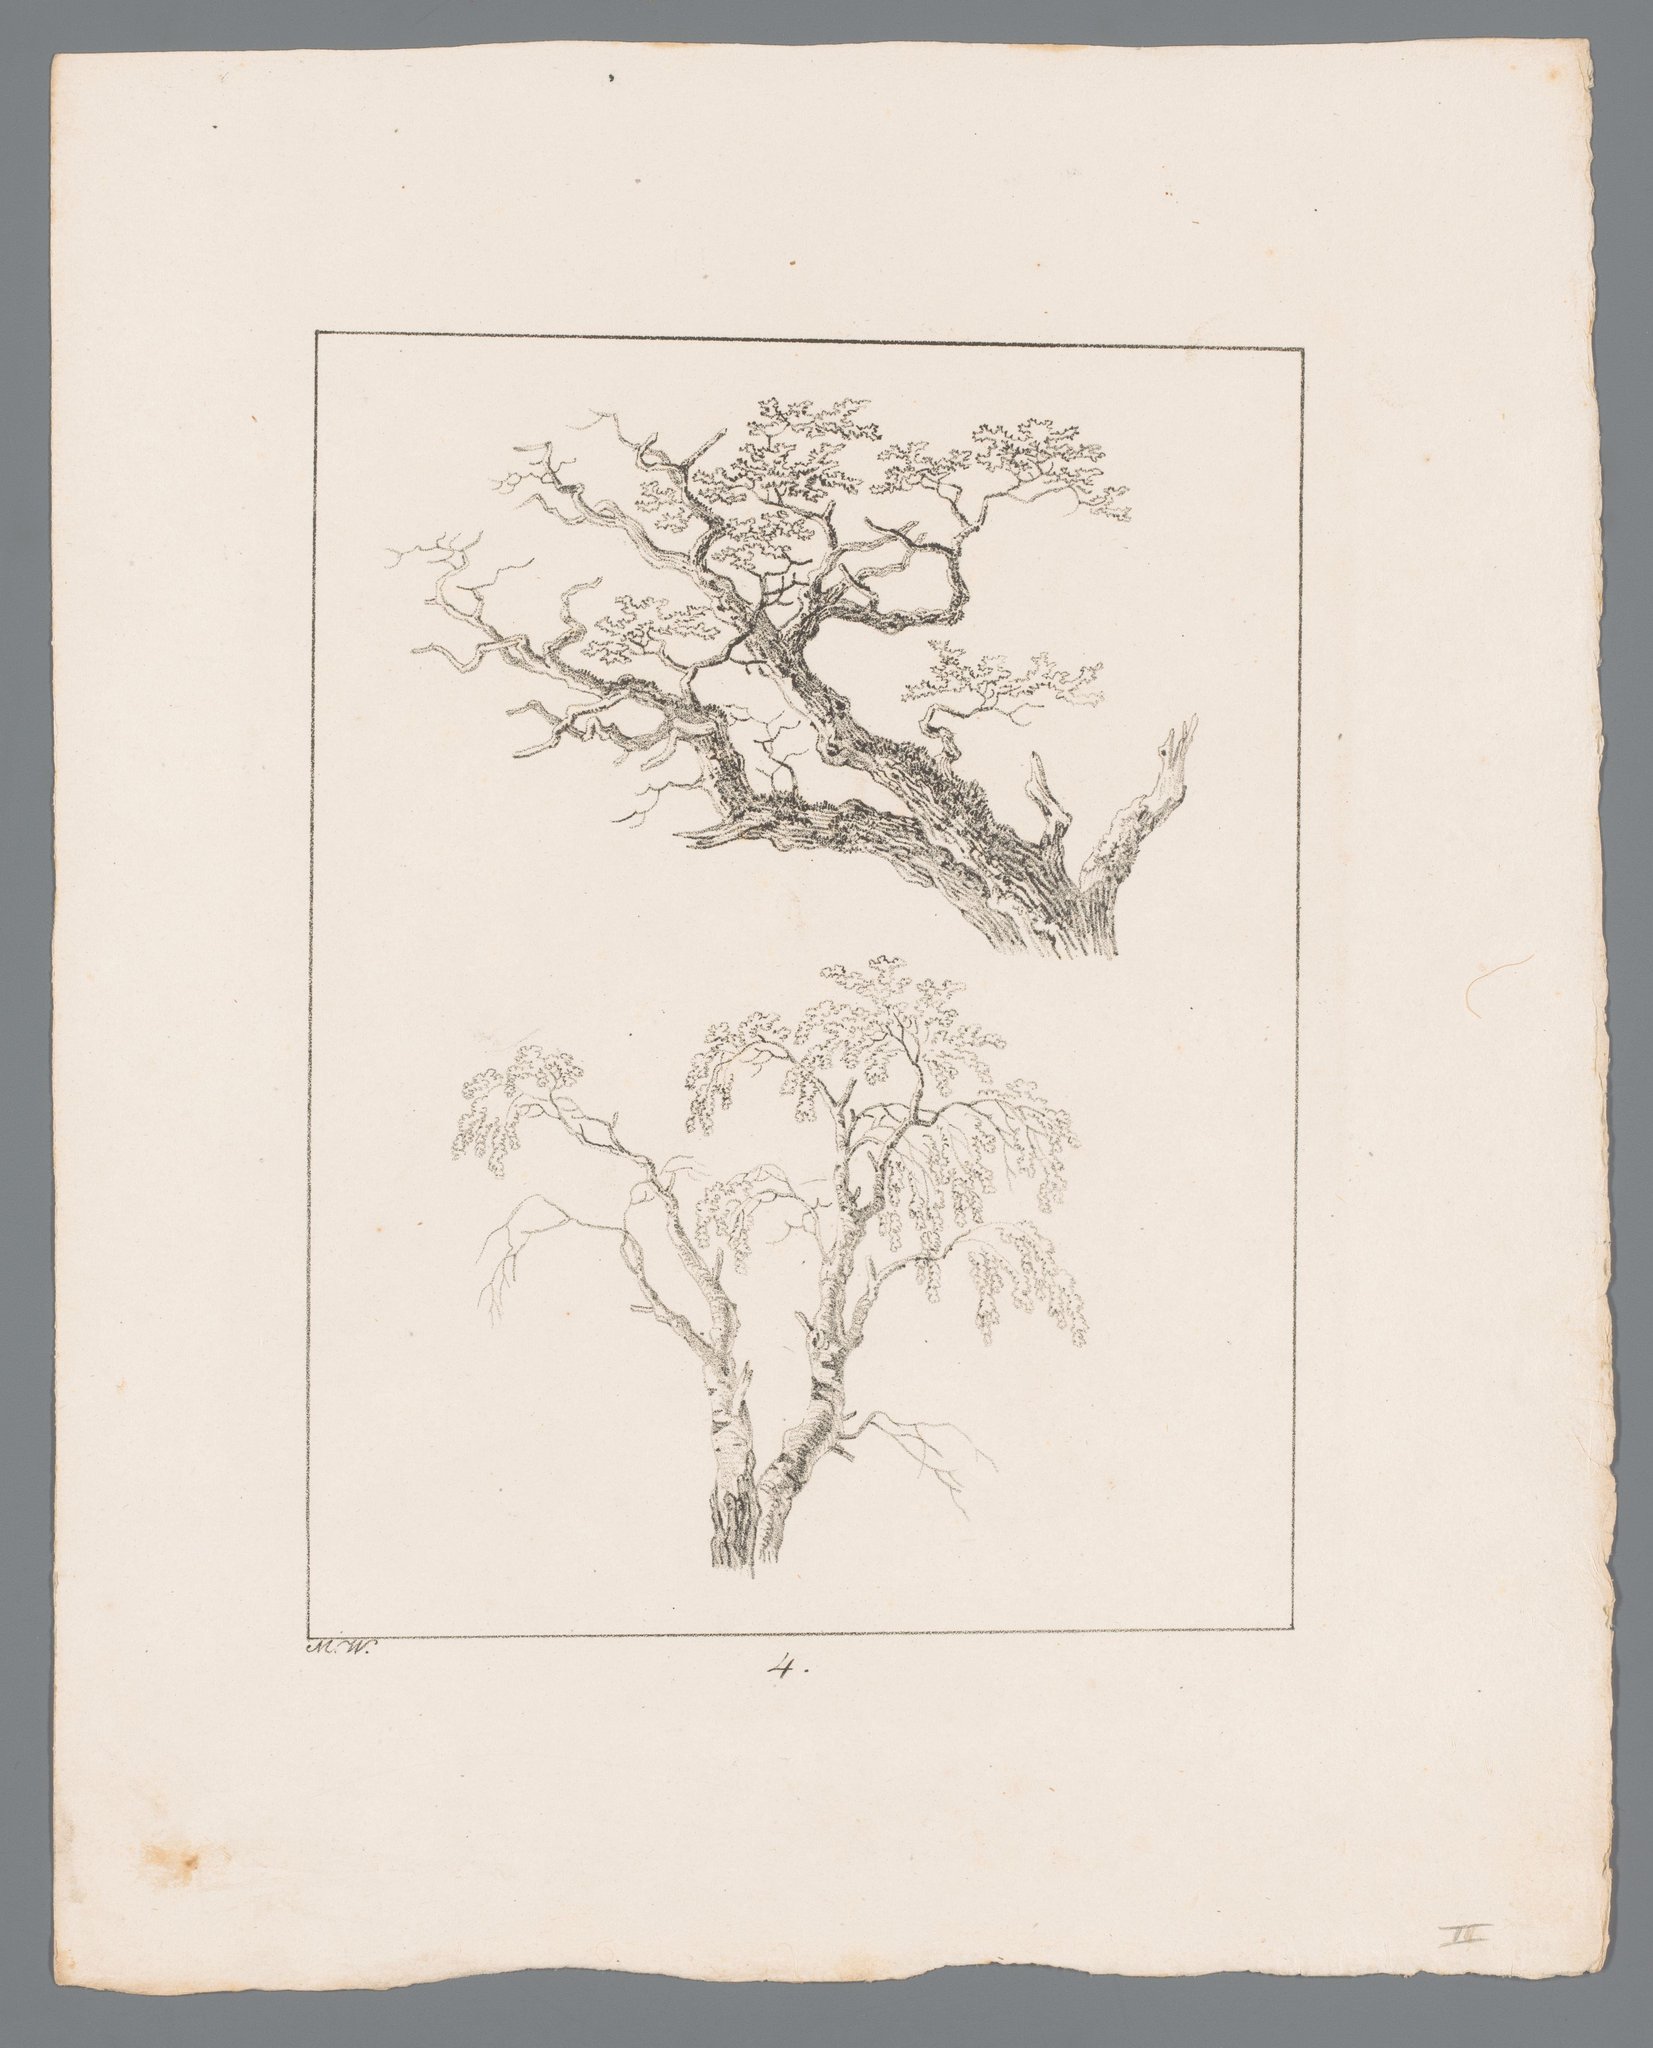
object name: print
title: Twee takken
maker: max josef wagenbauer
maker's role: print maker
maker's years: 1774-1829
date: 1823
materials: paper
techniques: lithograph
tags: trees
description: Onderdeel van een tweedelige serie waarvan het eerste deel bestaat uit een titelprent en twintig voorstellingen van takken, bladeren, bomen en landschappen.